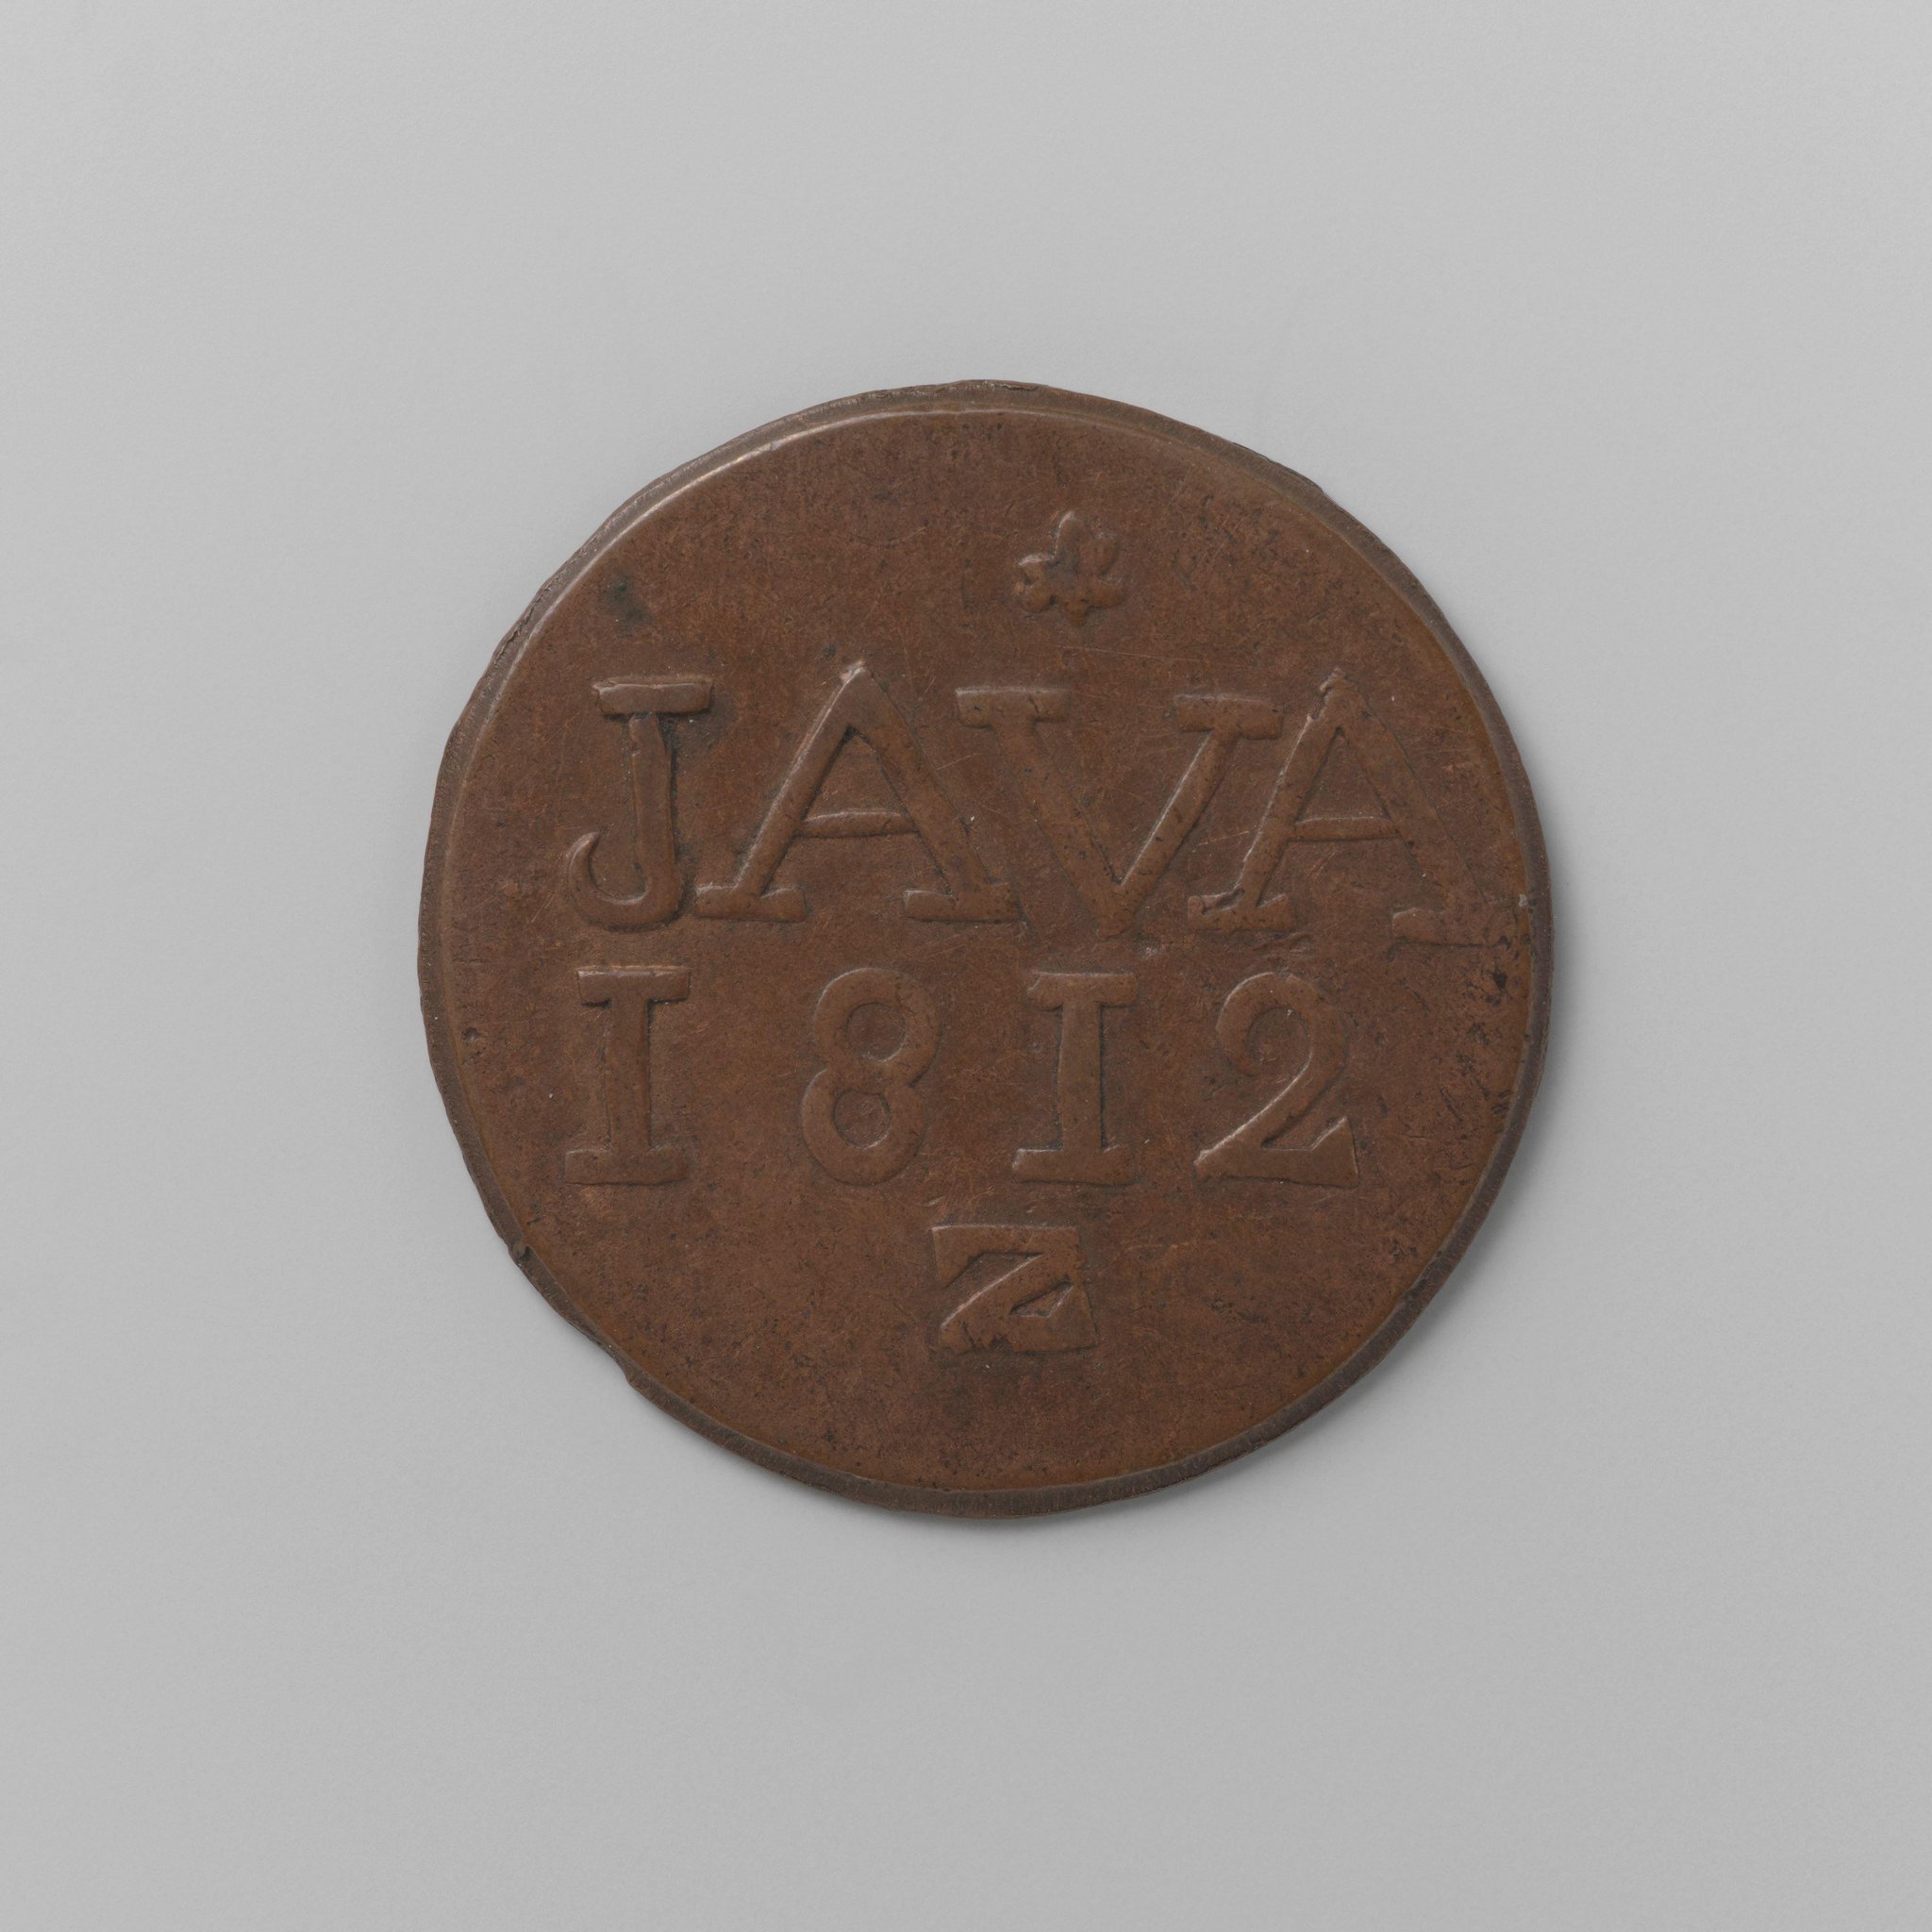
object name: coin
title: Duit voor Nederlands Indië tijdens Brits bestuur,1812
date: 1812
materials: copper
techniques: striking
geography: surabaya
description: Koperen munt. Voorzijde: monogram van de Engelse Oostindische Compagnie. Daarboven letter B [=British]. Keerzijde: eenregelig opschrift, waaronder jaartal. Boven opschrift muntteken en onder jaartal muntmeesterteken Z [=muntmeester Zwekkert].